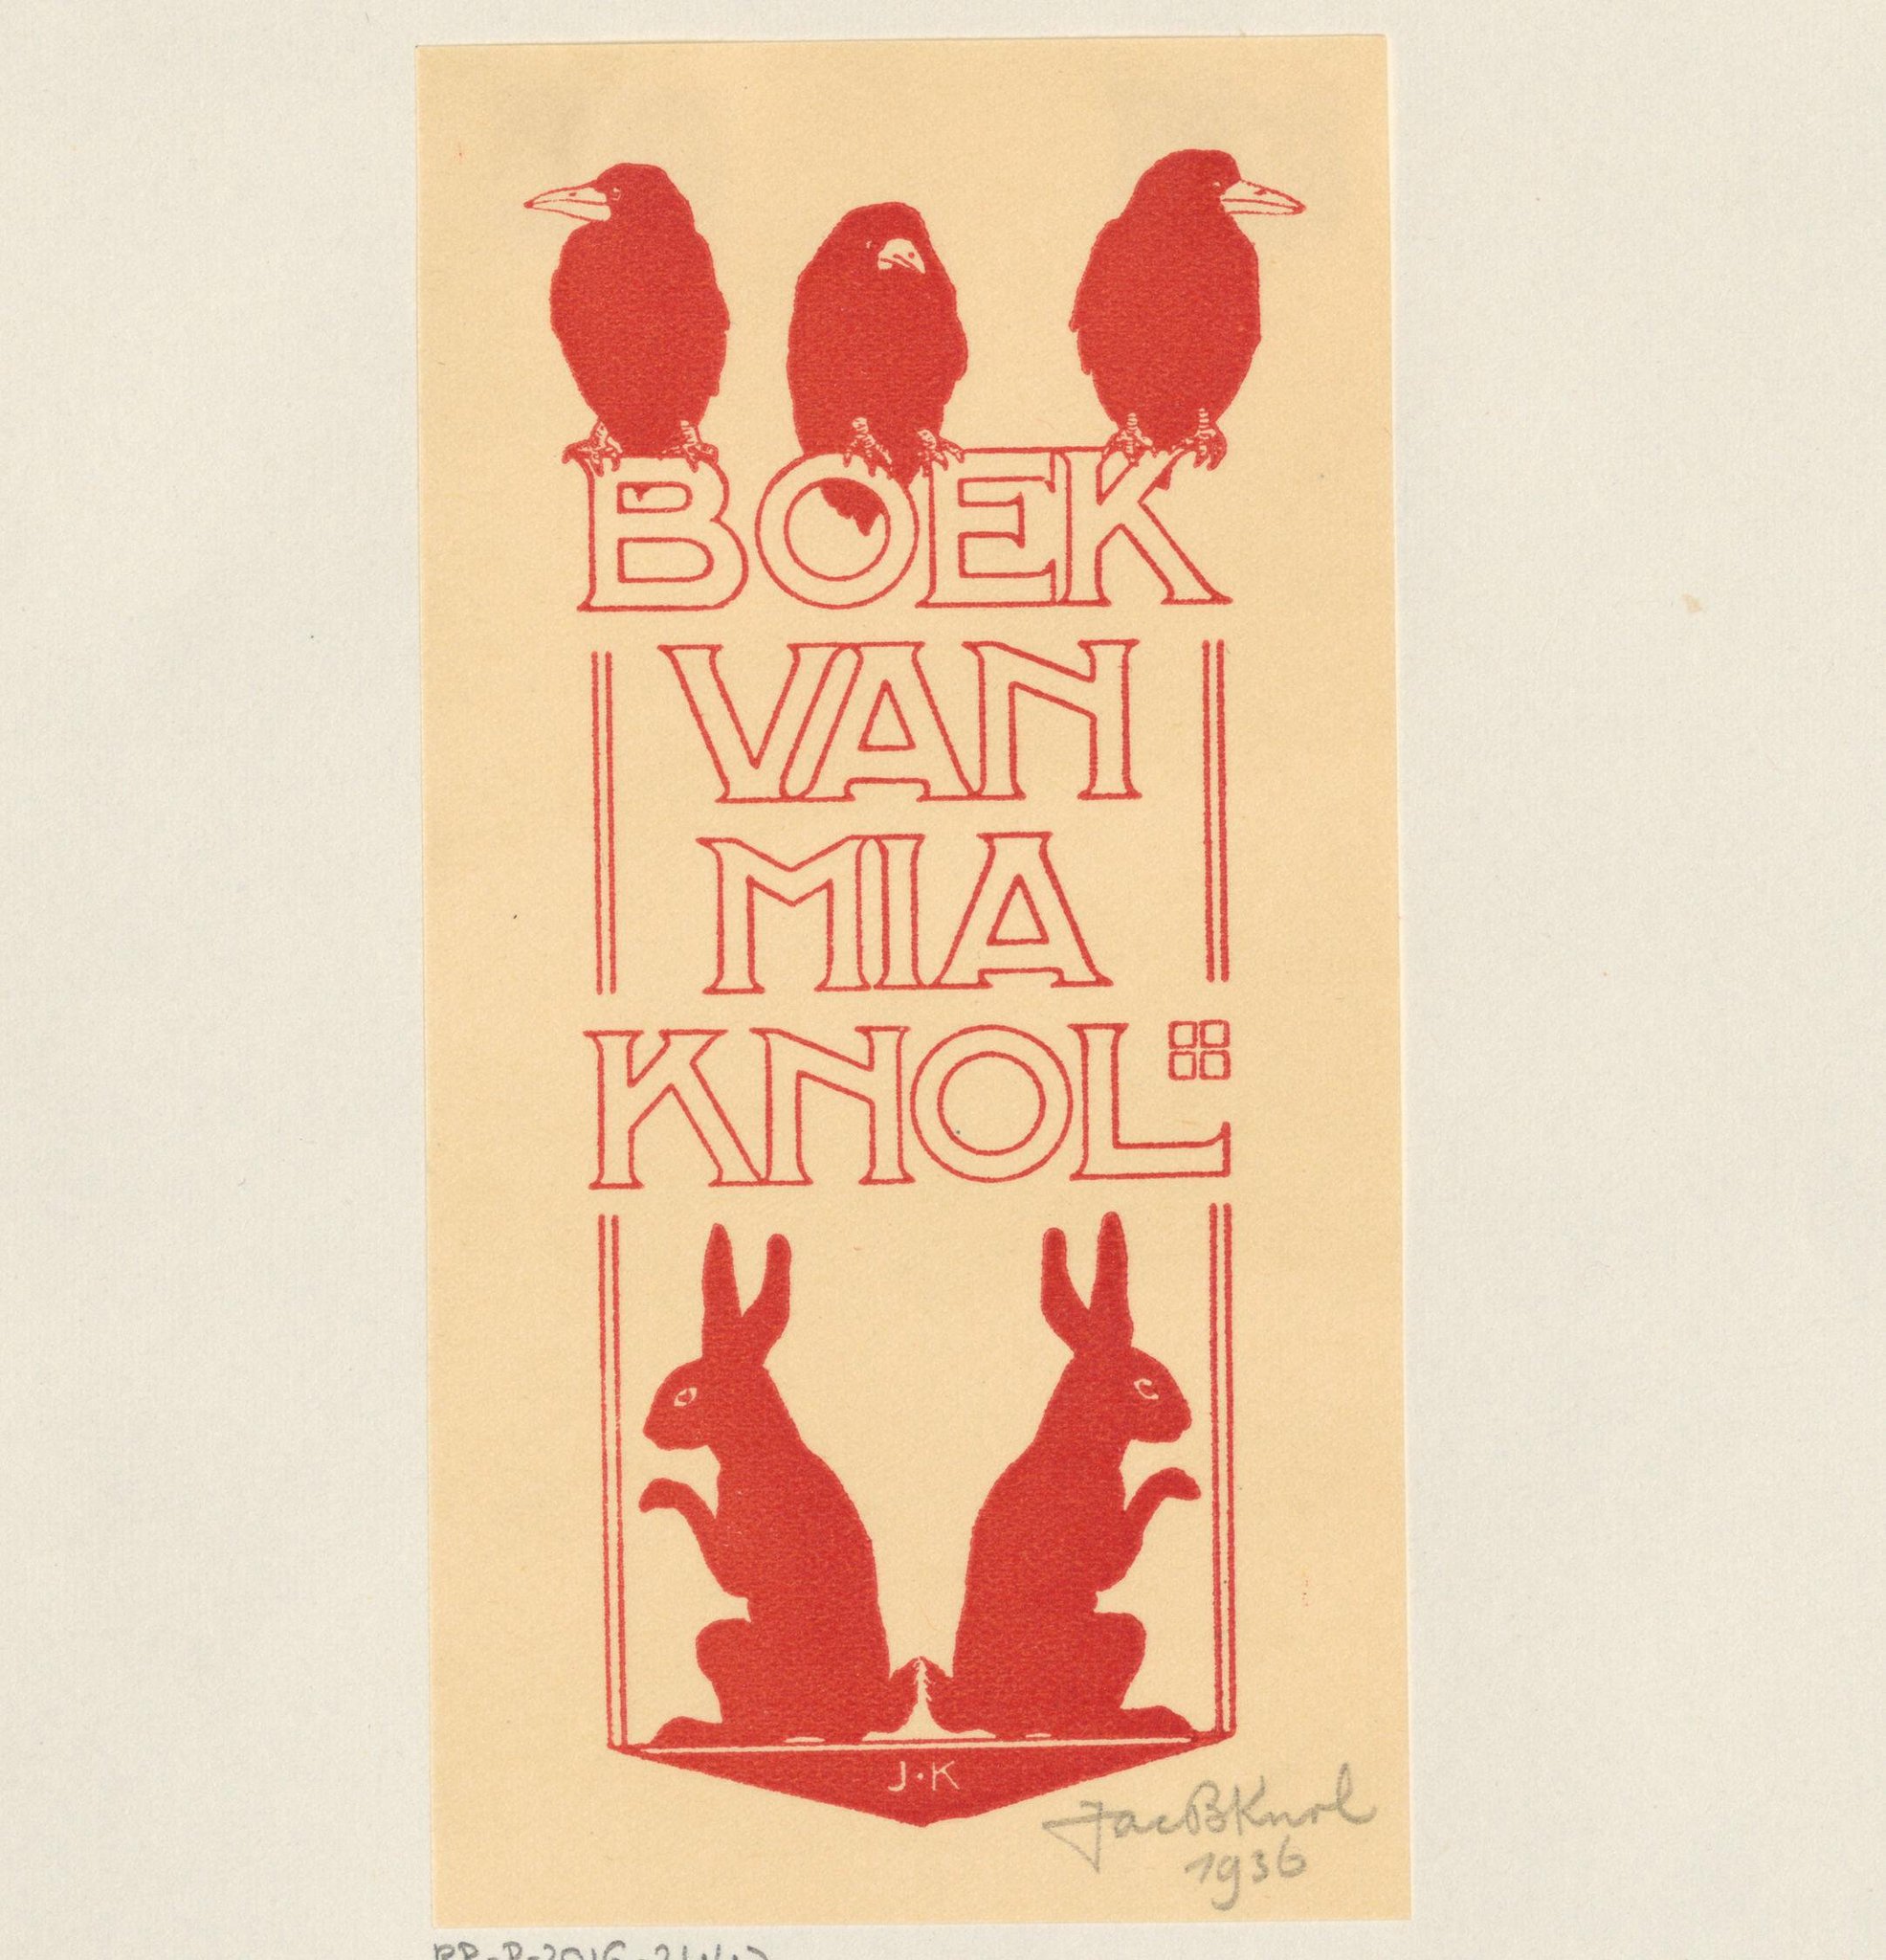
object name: bookplate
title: Ex libris van Mia Knol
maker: jac. b. knol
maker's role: verzamelaar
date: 1936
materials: paper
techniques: printing block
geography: netherlands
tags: song-birds: raven, rodents: rabbit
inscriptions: signature and date: ‘Jac B Knol / 1936’